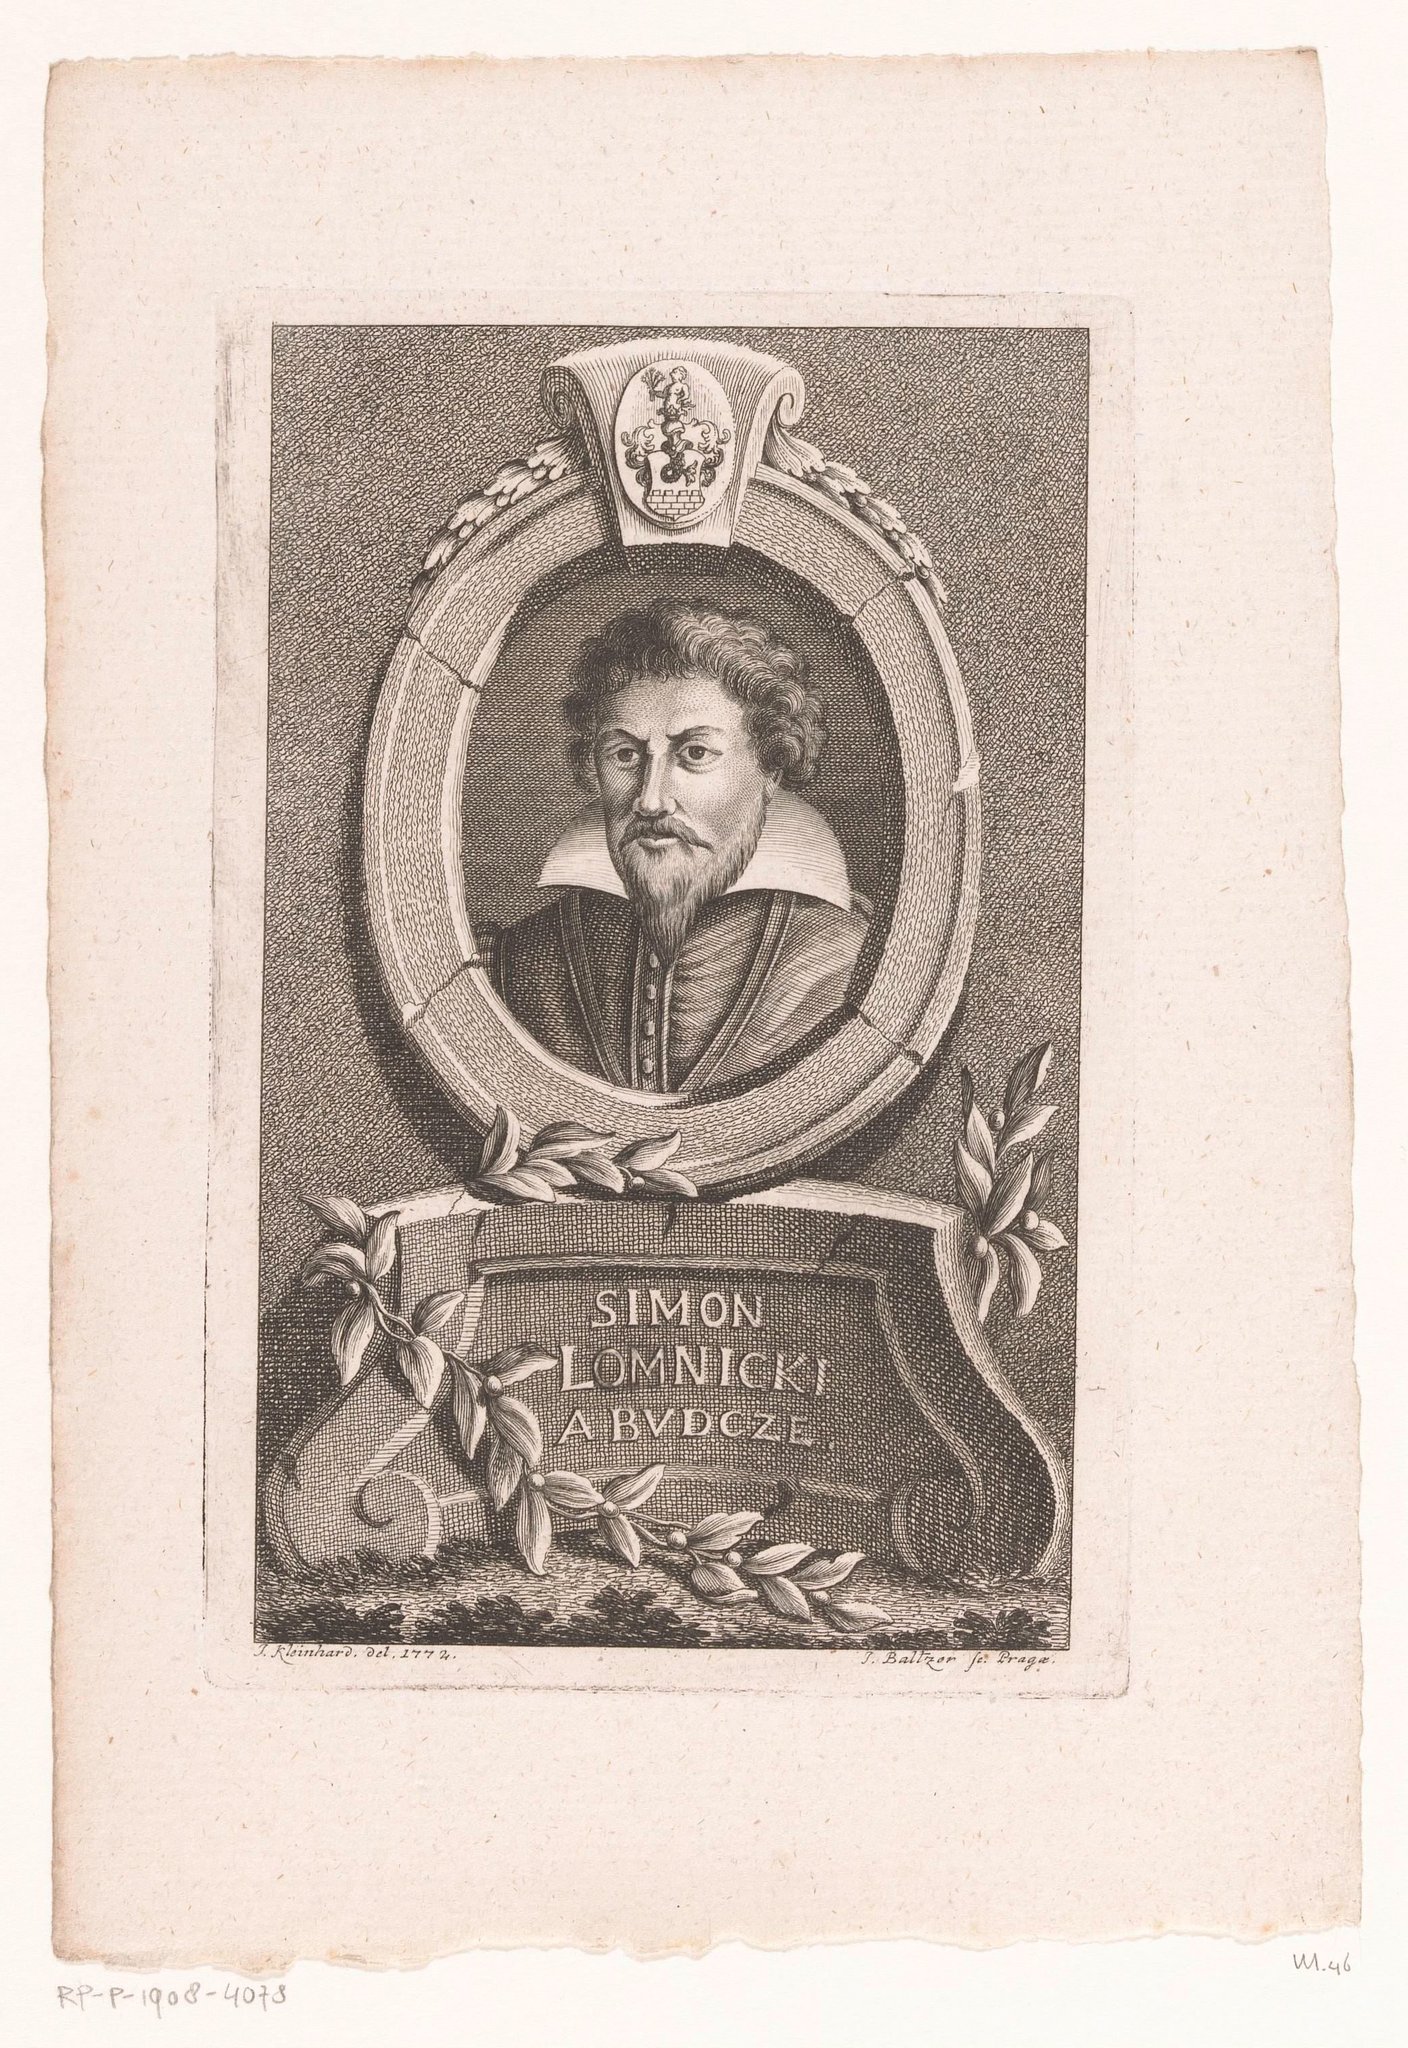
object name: print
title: Simon Lomnicki a Budcze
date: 1772-1799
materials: paper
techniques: engraving, etching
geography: prague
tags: prague, historical persons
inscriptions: collector's mark: Lugt 2228